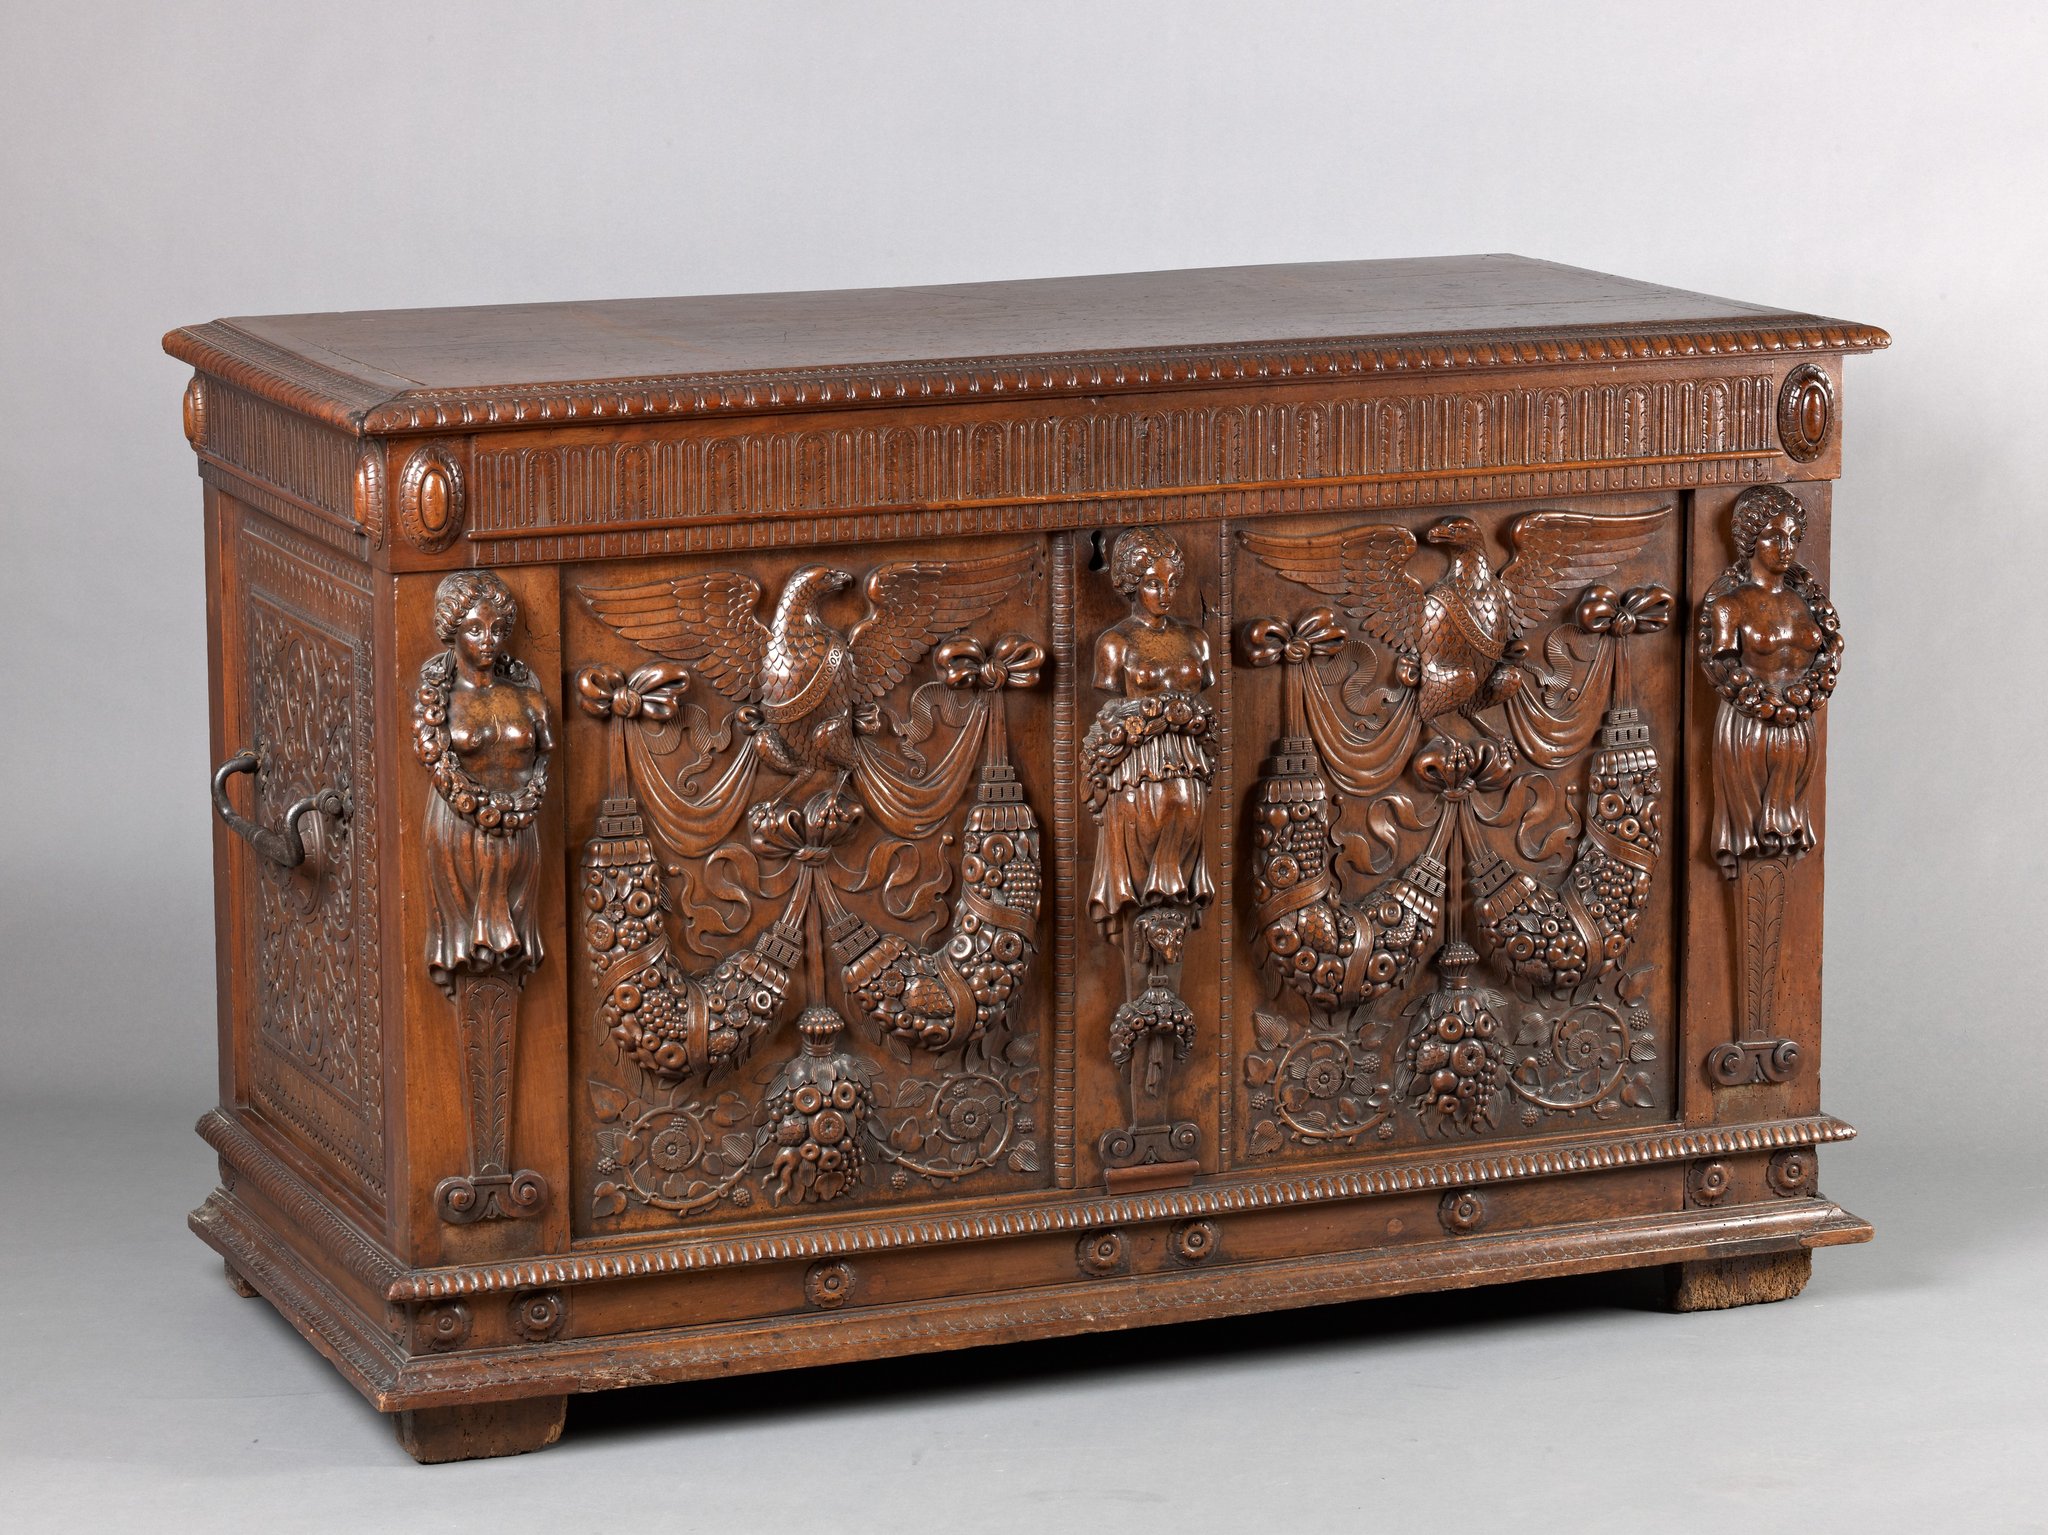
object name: chest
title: Credence (chest)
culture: french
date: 1834-1866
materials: wood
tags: eagles